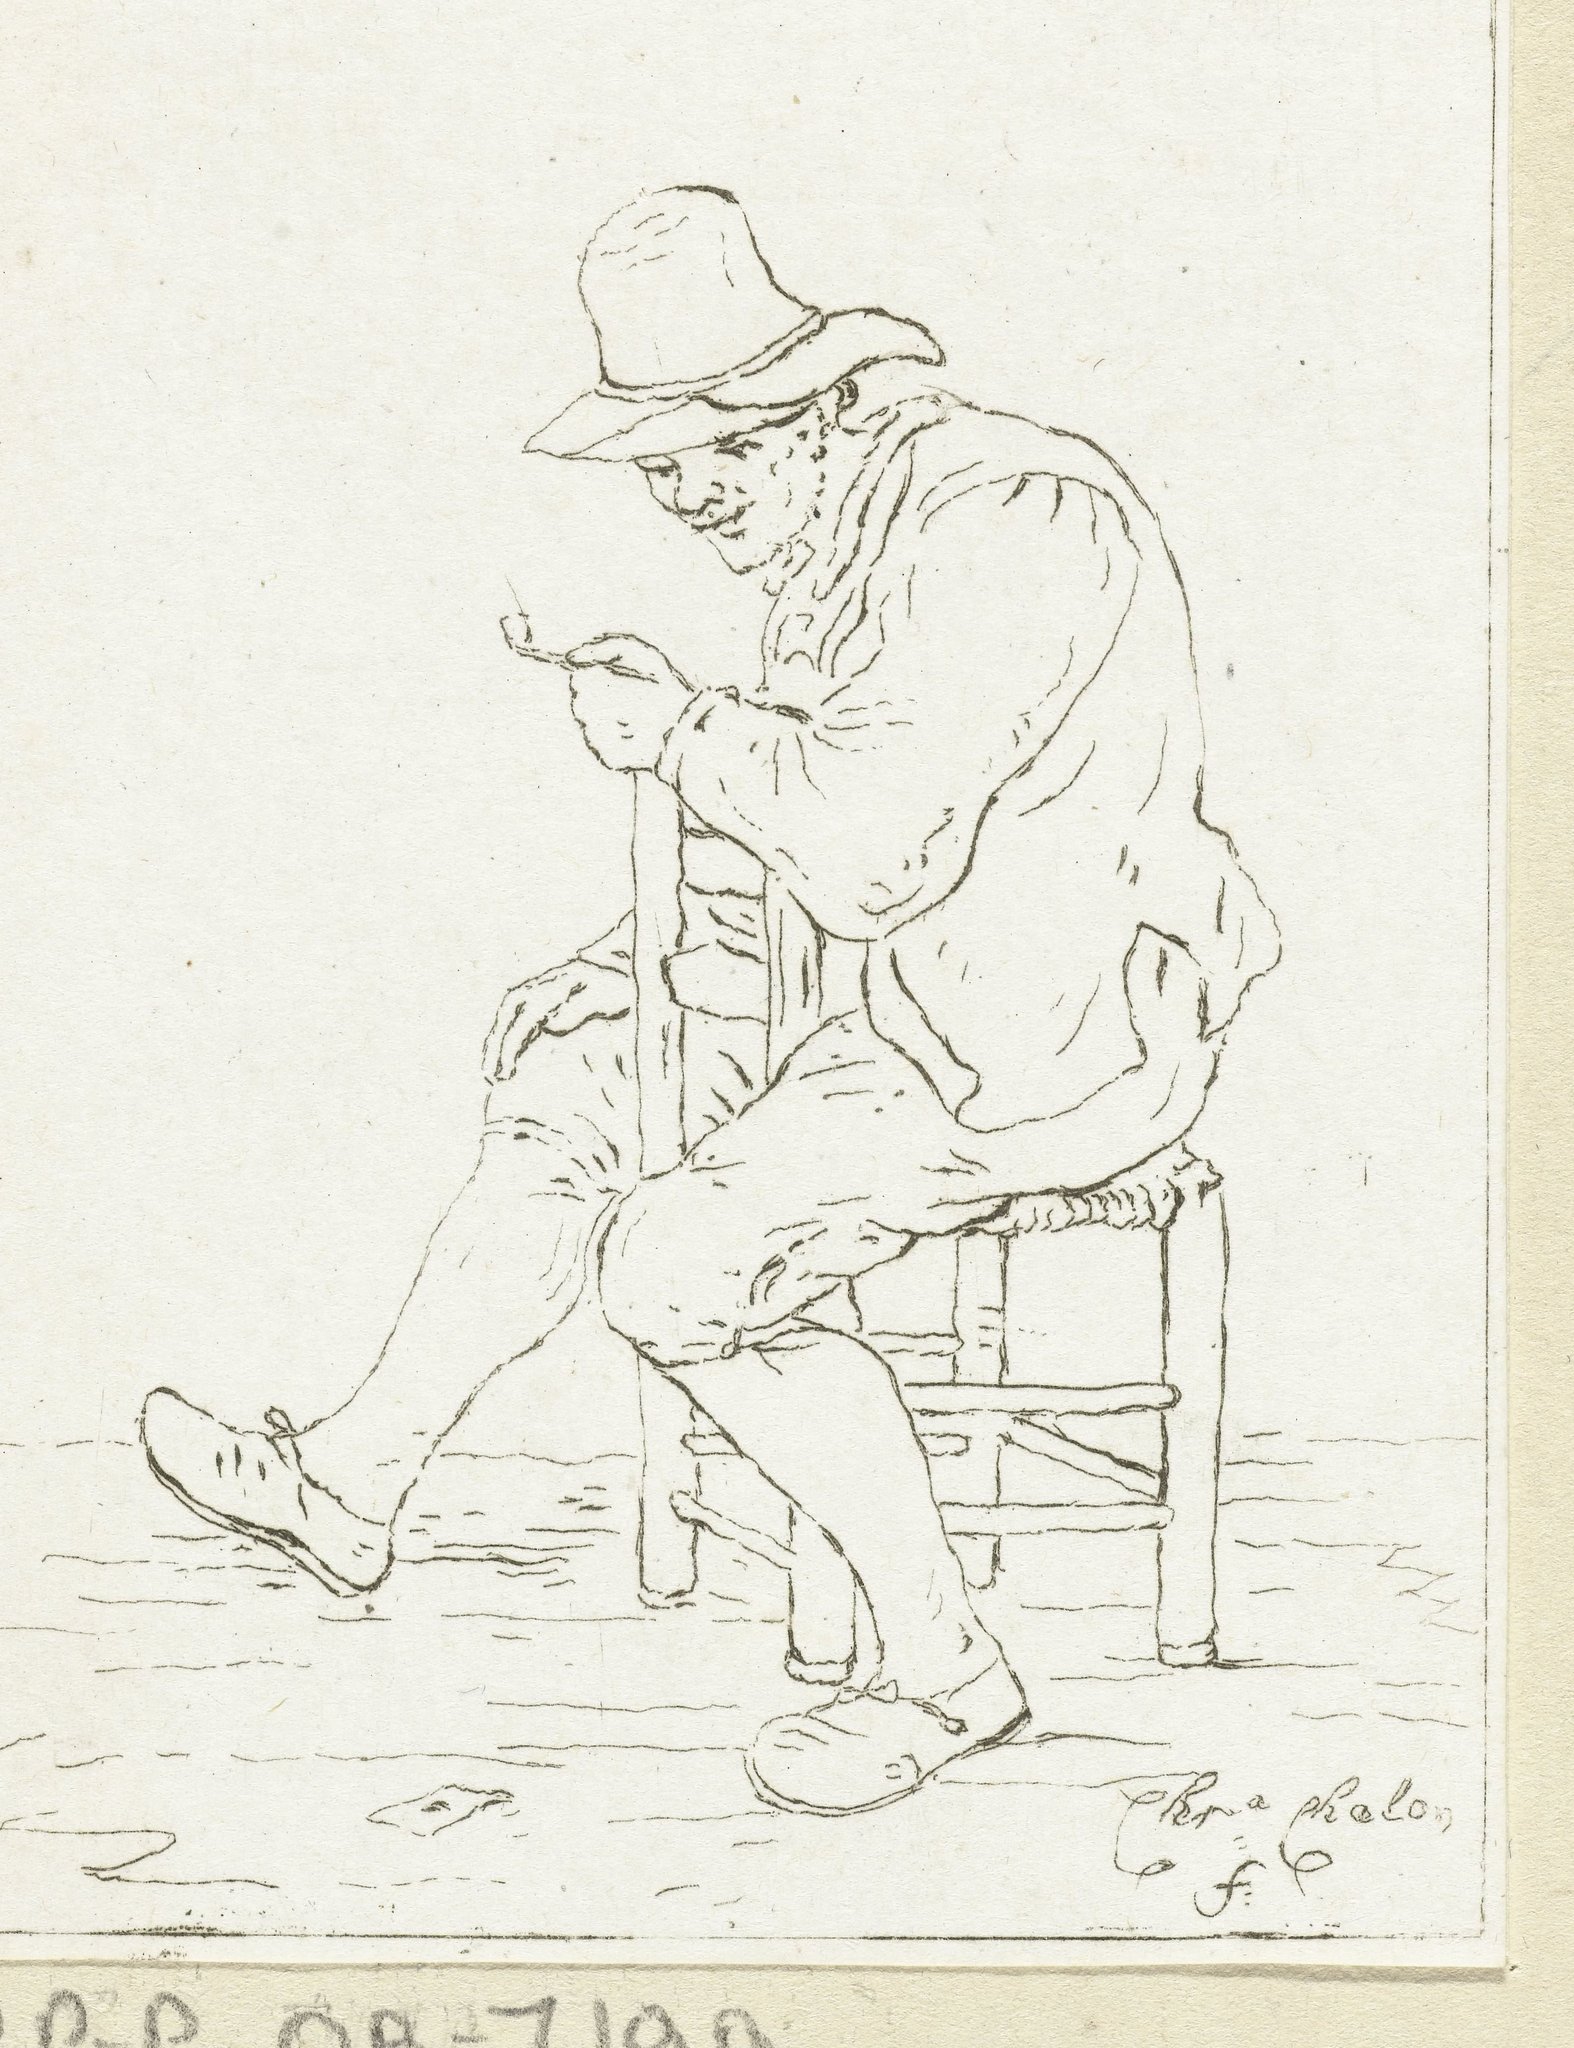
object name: print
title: Zittende man met pijp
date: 1779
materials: paper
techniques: etching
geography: leiden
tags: pipe ~ tobacco, farmers, drinks, stimulants, drugs (+ taking (particular) foodstuffs: eating, drinking, smoking, chewing, etc.)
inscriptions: collector's mark: Lugt 2228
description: Een boer zit omgekeerd op een stoel. In zijn handen heeft hij een smeulende pijp. Profiel naar links.